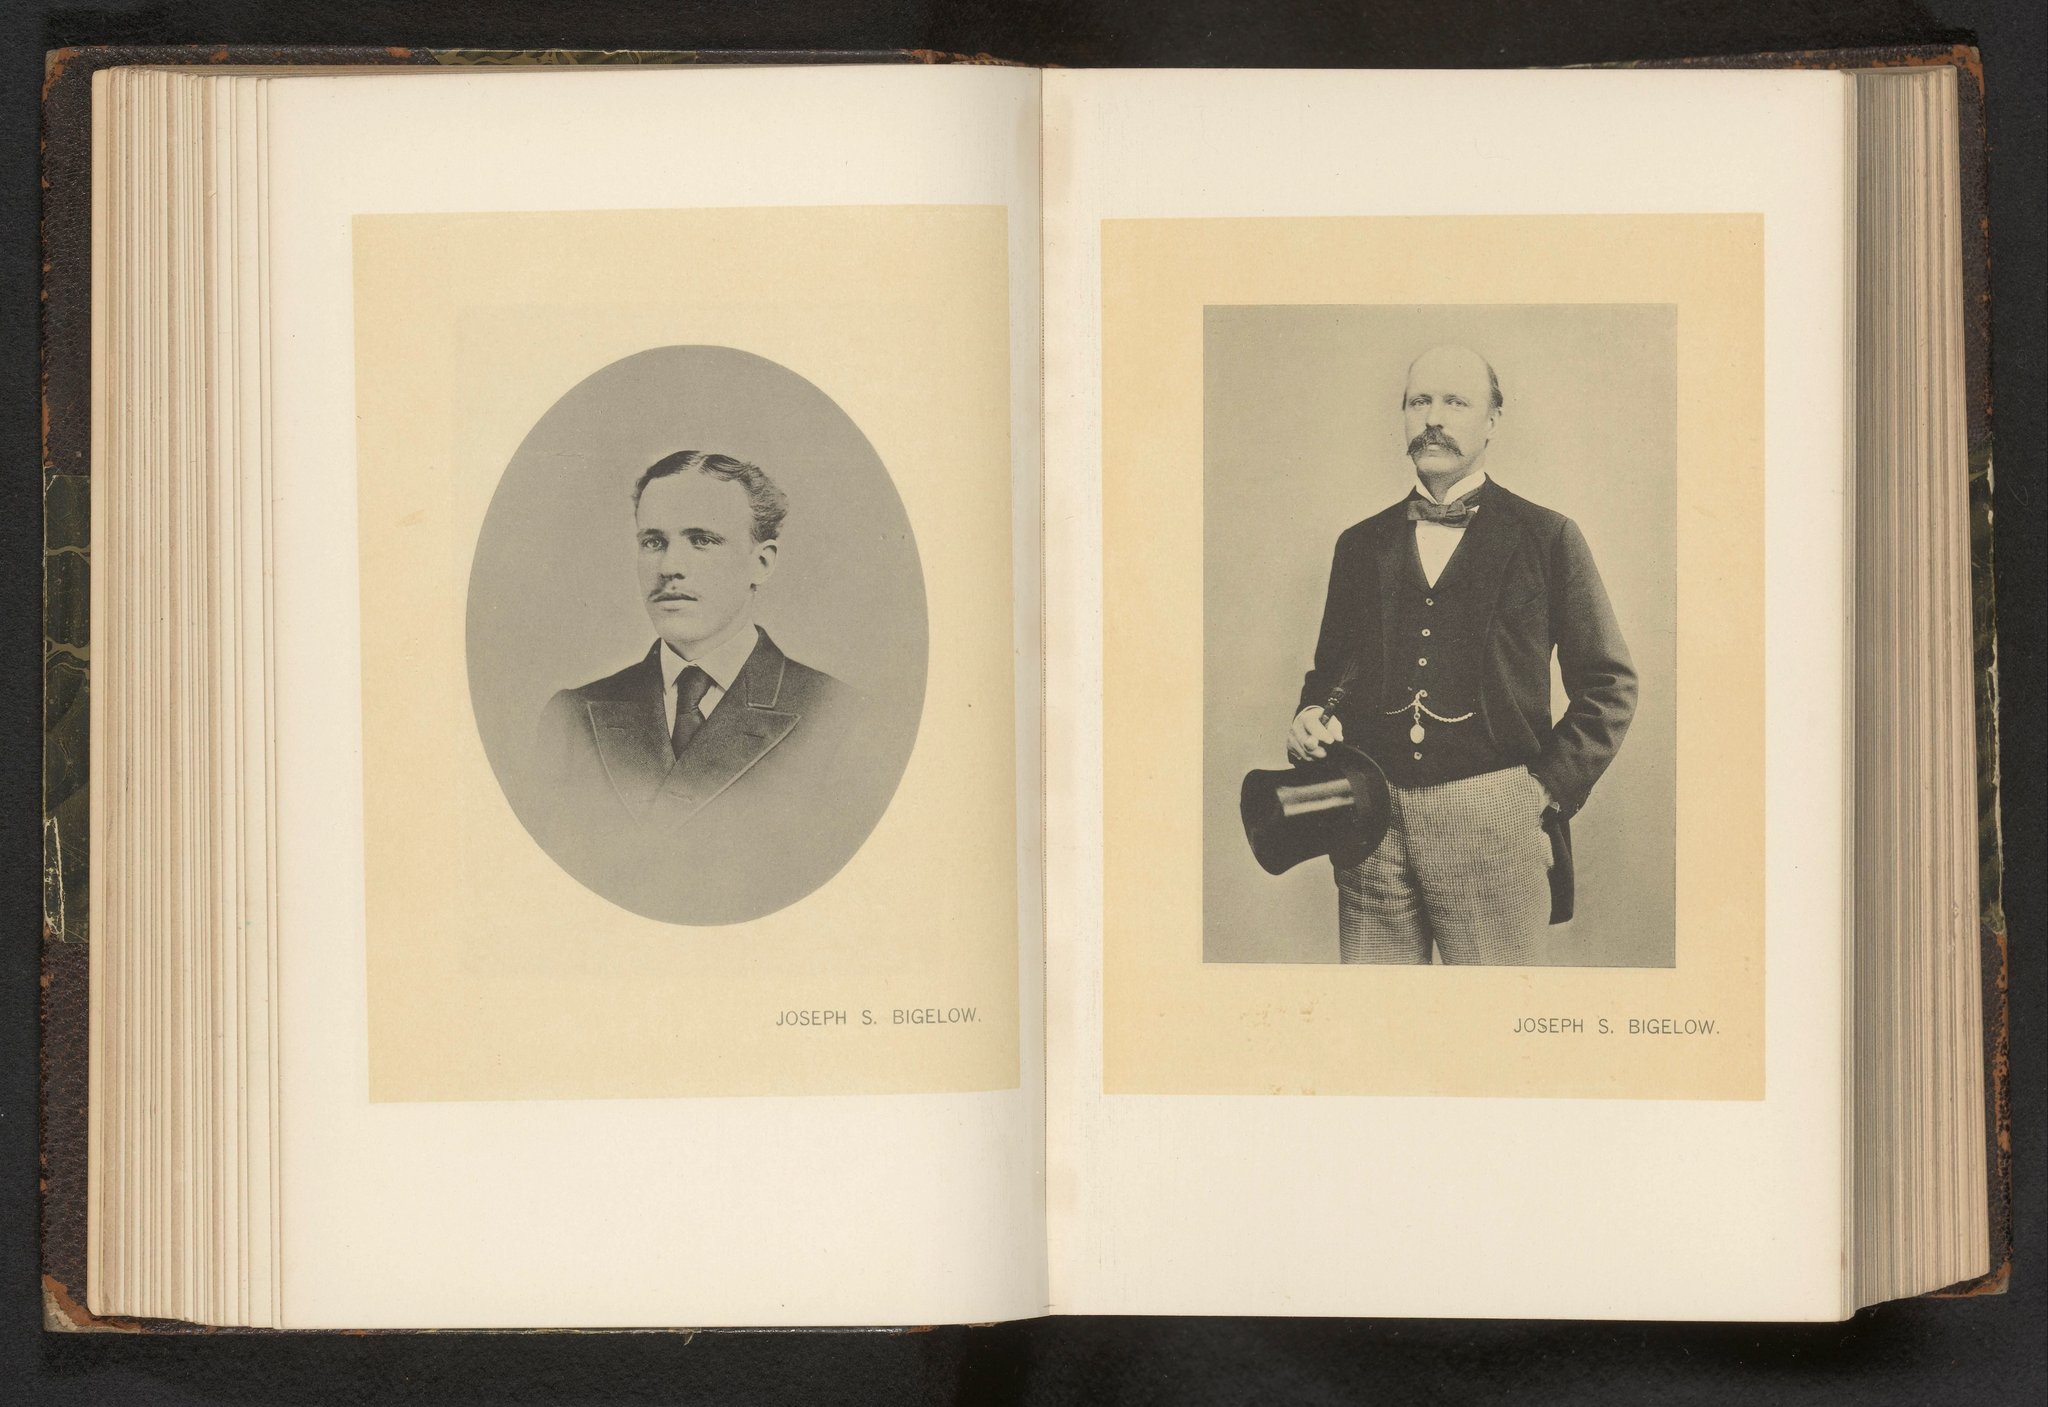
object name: photomechanical print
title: Joseph S. Bigelow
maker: Anonymous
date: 1889-1894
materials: paper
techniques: photoaquatint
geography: boston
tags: adult man